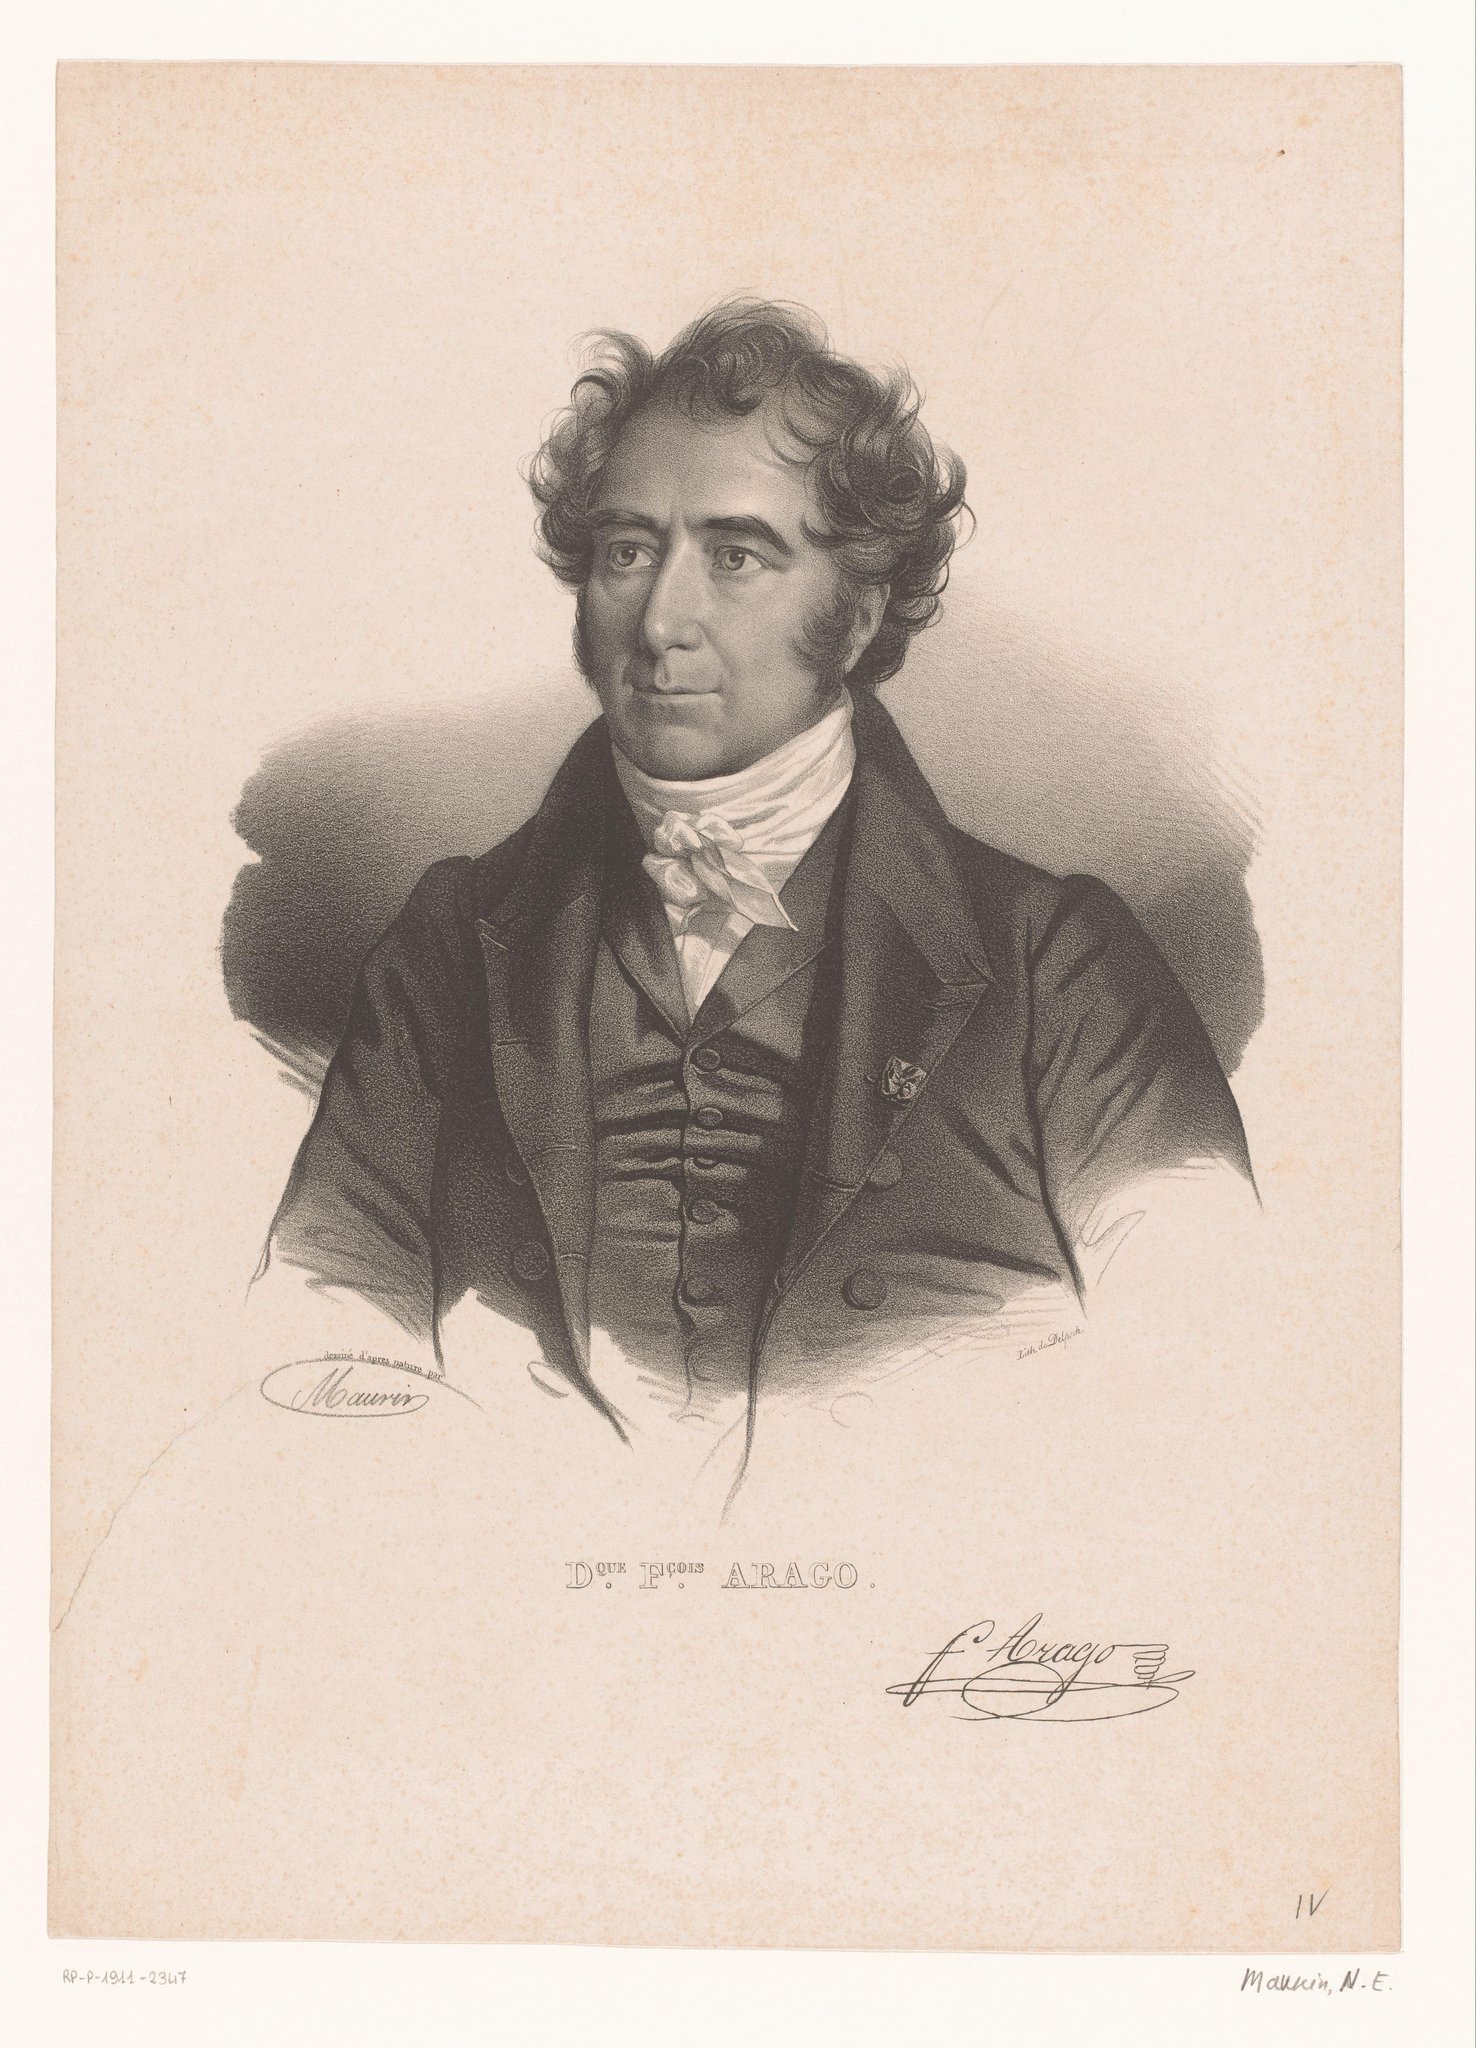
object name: print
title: Portret van François Arago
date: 1825-1842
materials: paper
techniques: lithograph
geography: paris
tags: paris, historical persons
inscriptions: collector's mark: Lugt 2228